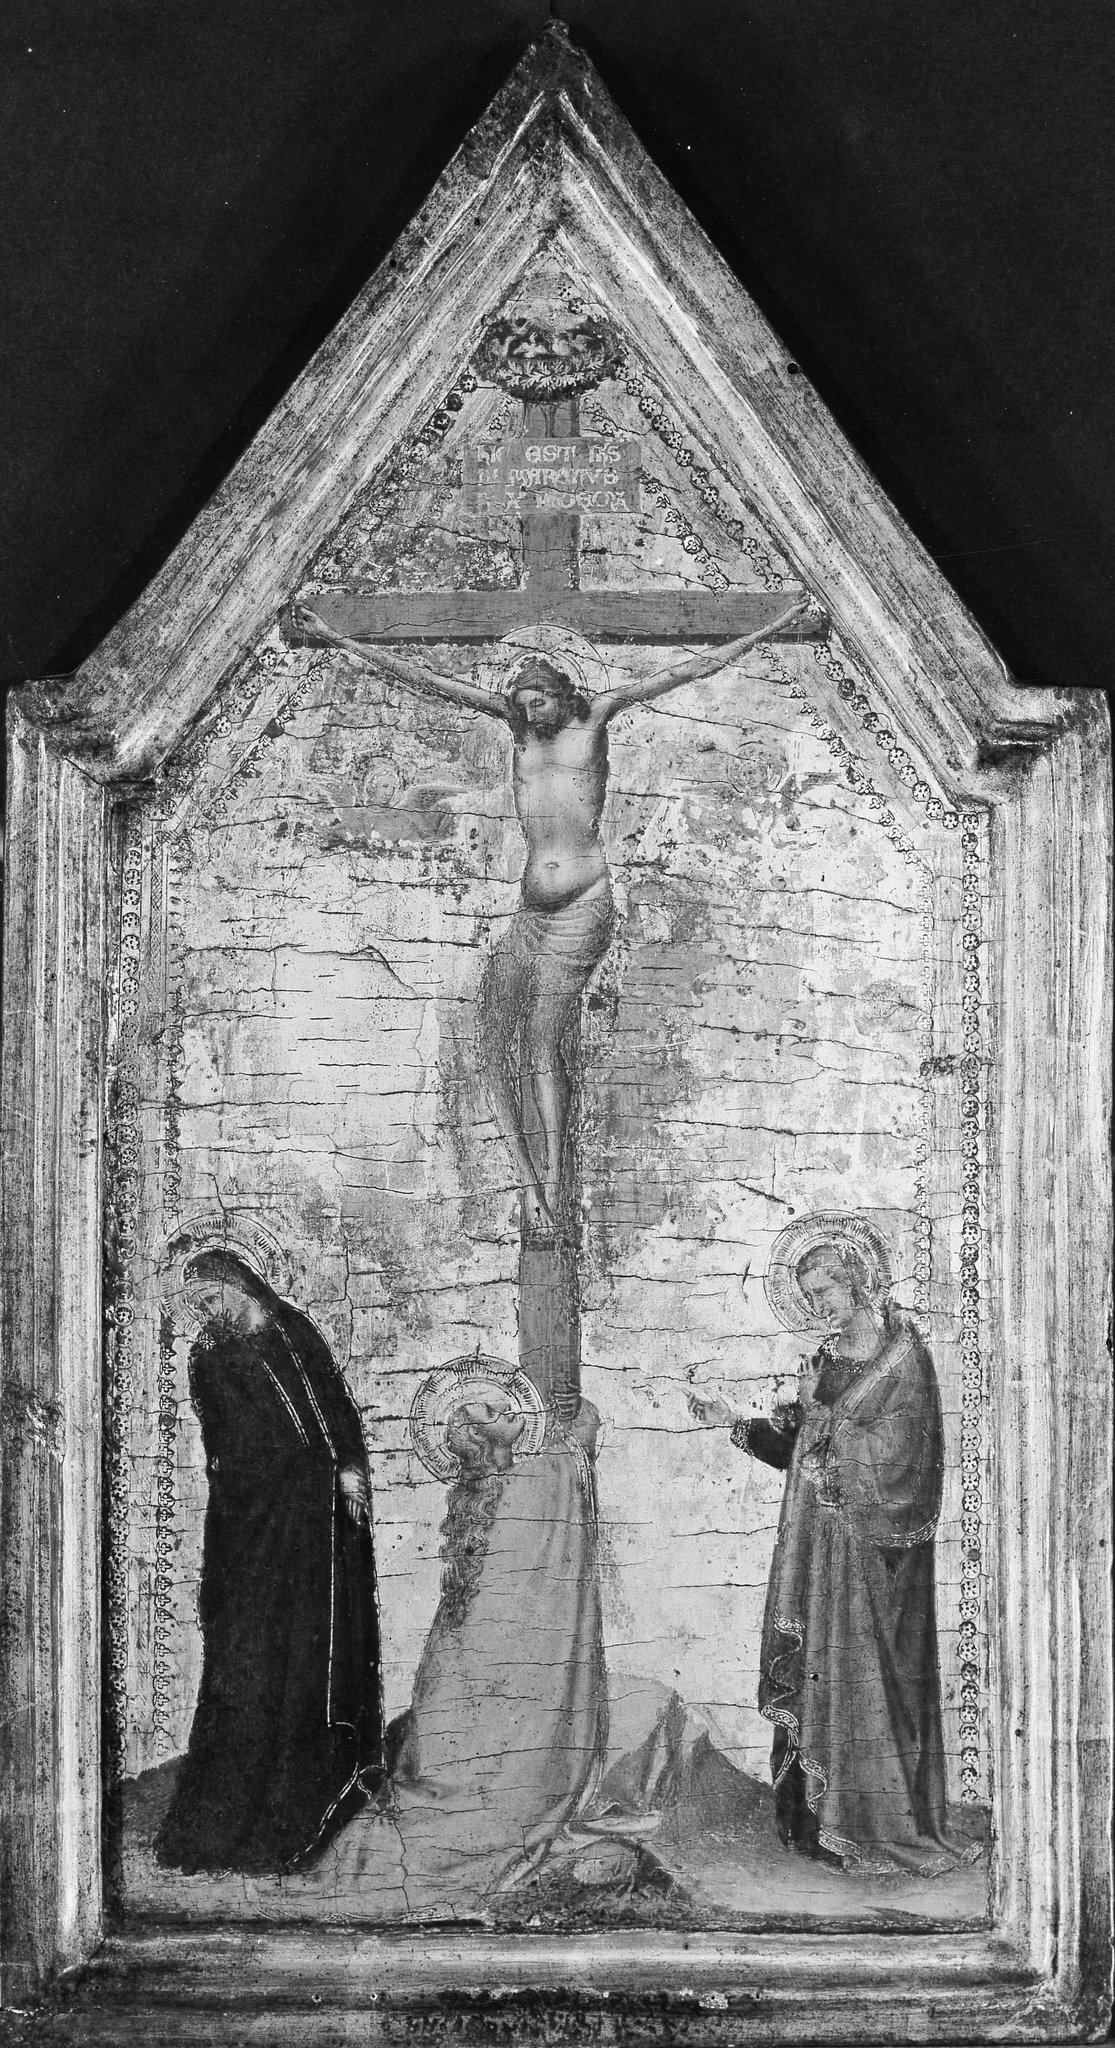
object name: painting, central panel of a portable altarpiece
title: The Crucifixion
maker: bernardo daddi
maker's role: artist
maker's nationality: italian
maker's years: 1290-1348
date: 1327-1348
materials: gold leaf, paint, wood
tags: christ,mary magdalene,saint john the evangelist,virgin mary,crucifixion